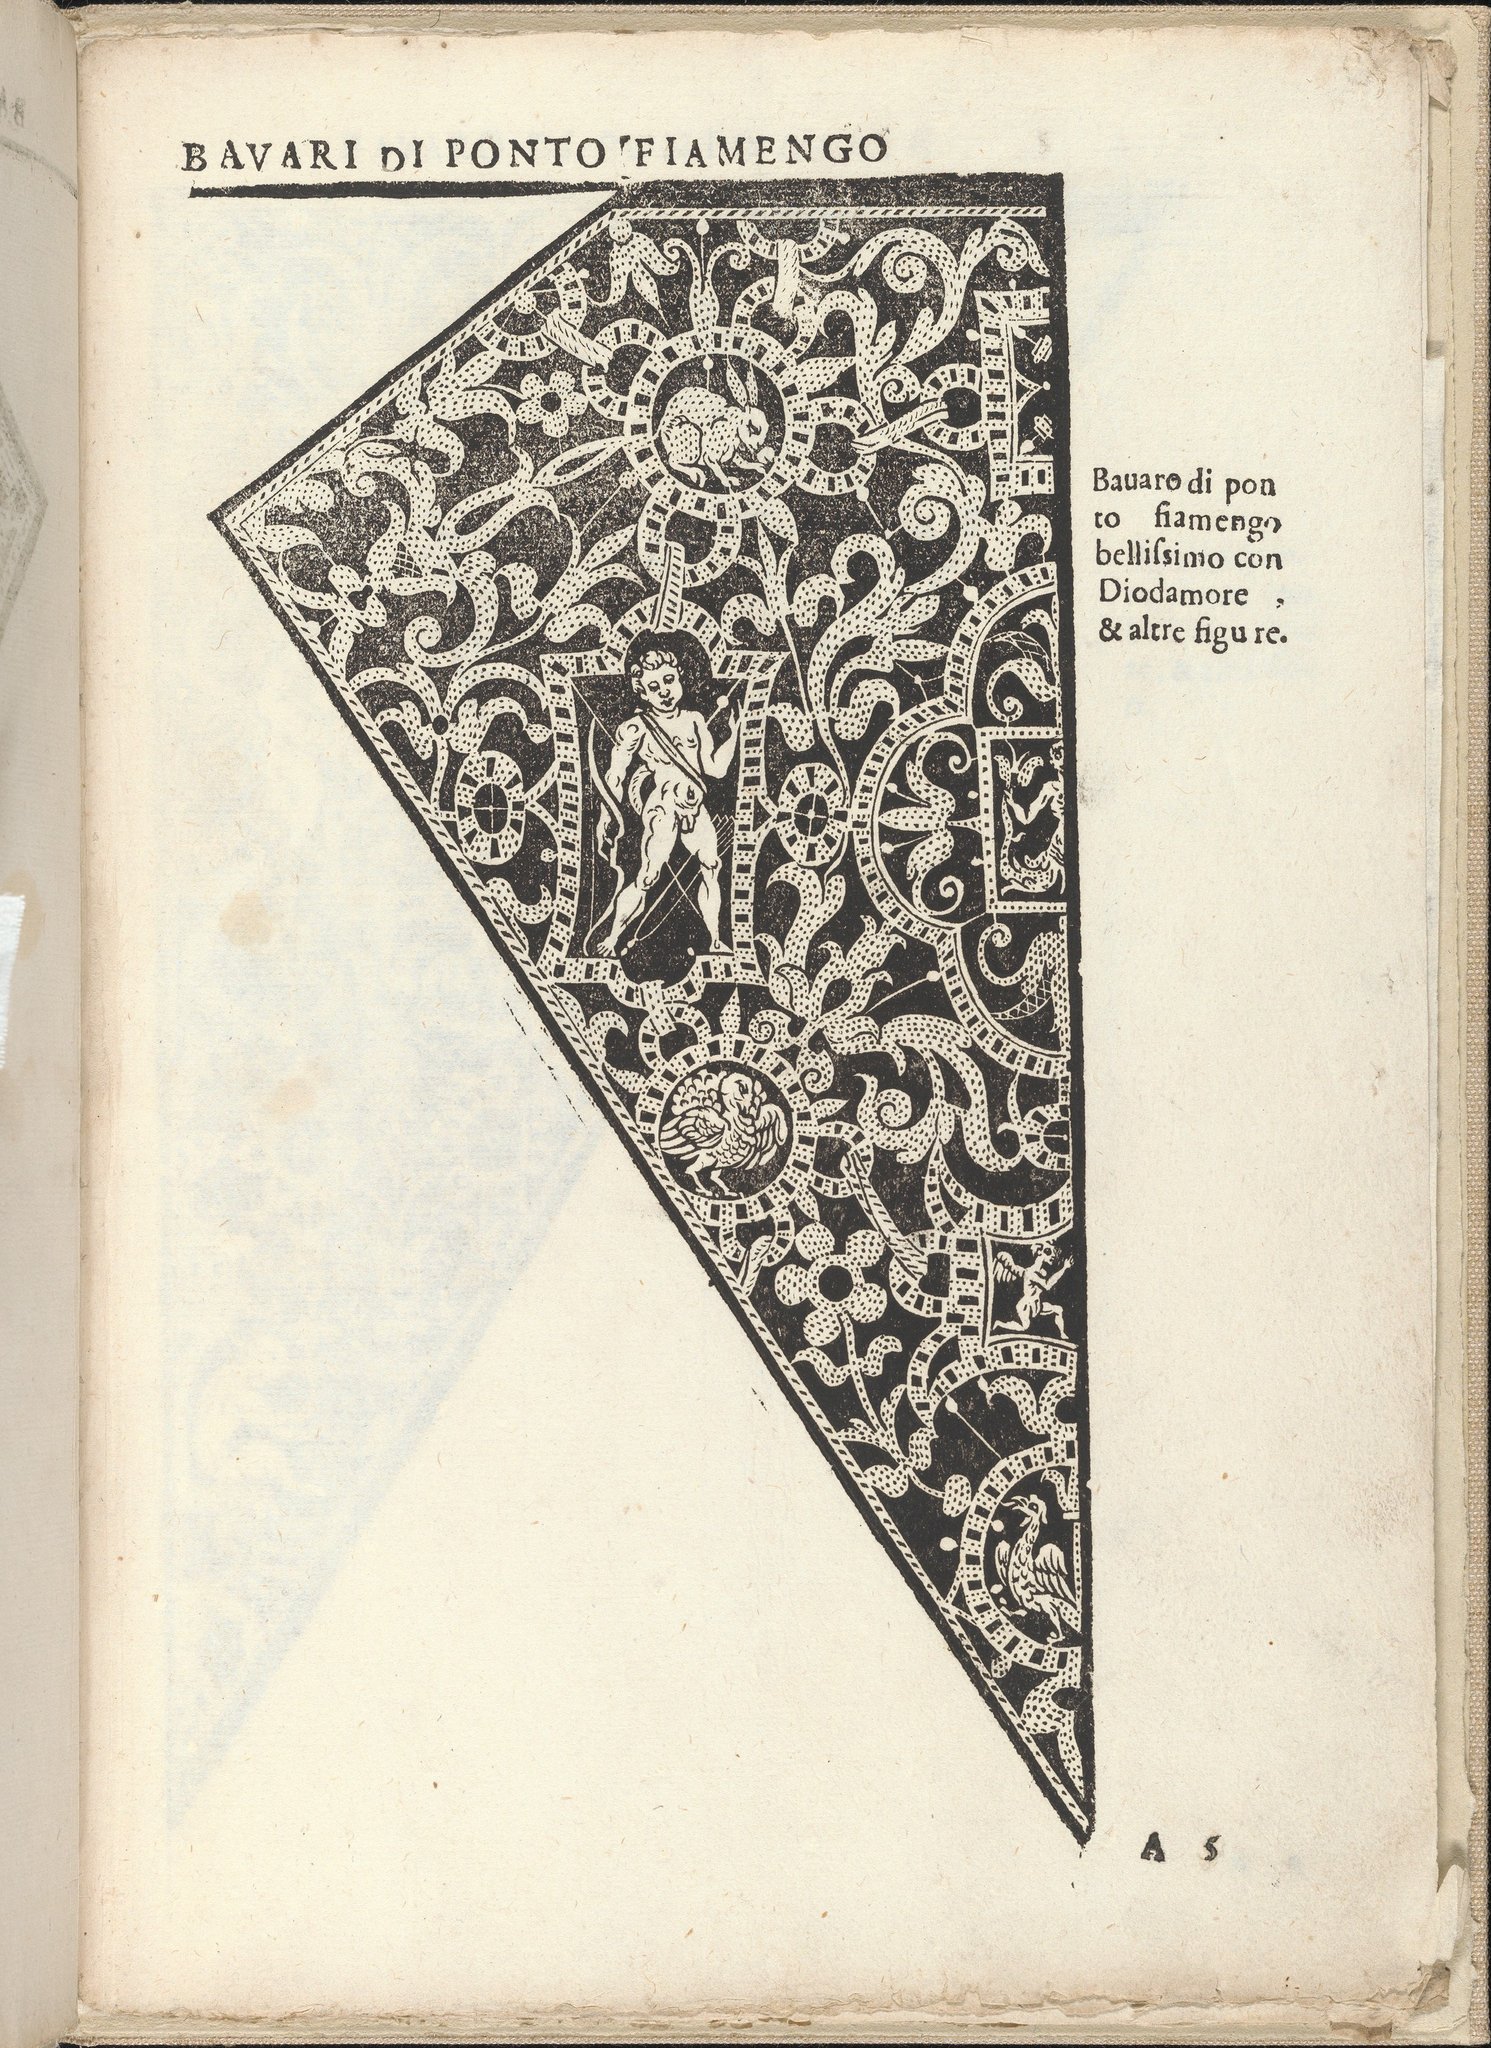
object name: book print ornament architecture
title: Ornamento nobile...Fatta da Lucretia Romana (Libro V of the Corona), page 5 (recto)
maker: cesare vecellio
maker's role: author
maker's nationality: italian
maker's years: 1521-1601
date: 1620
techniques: woodcut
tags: ornament